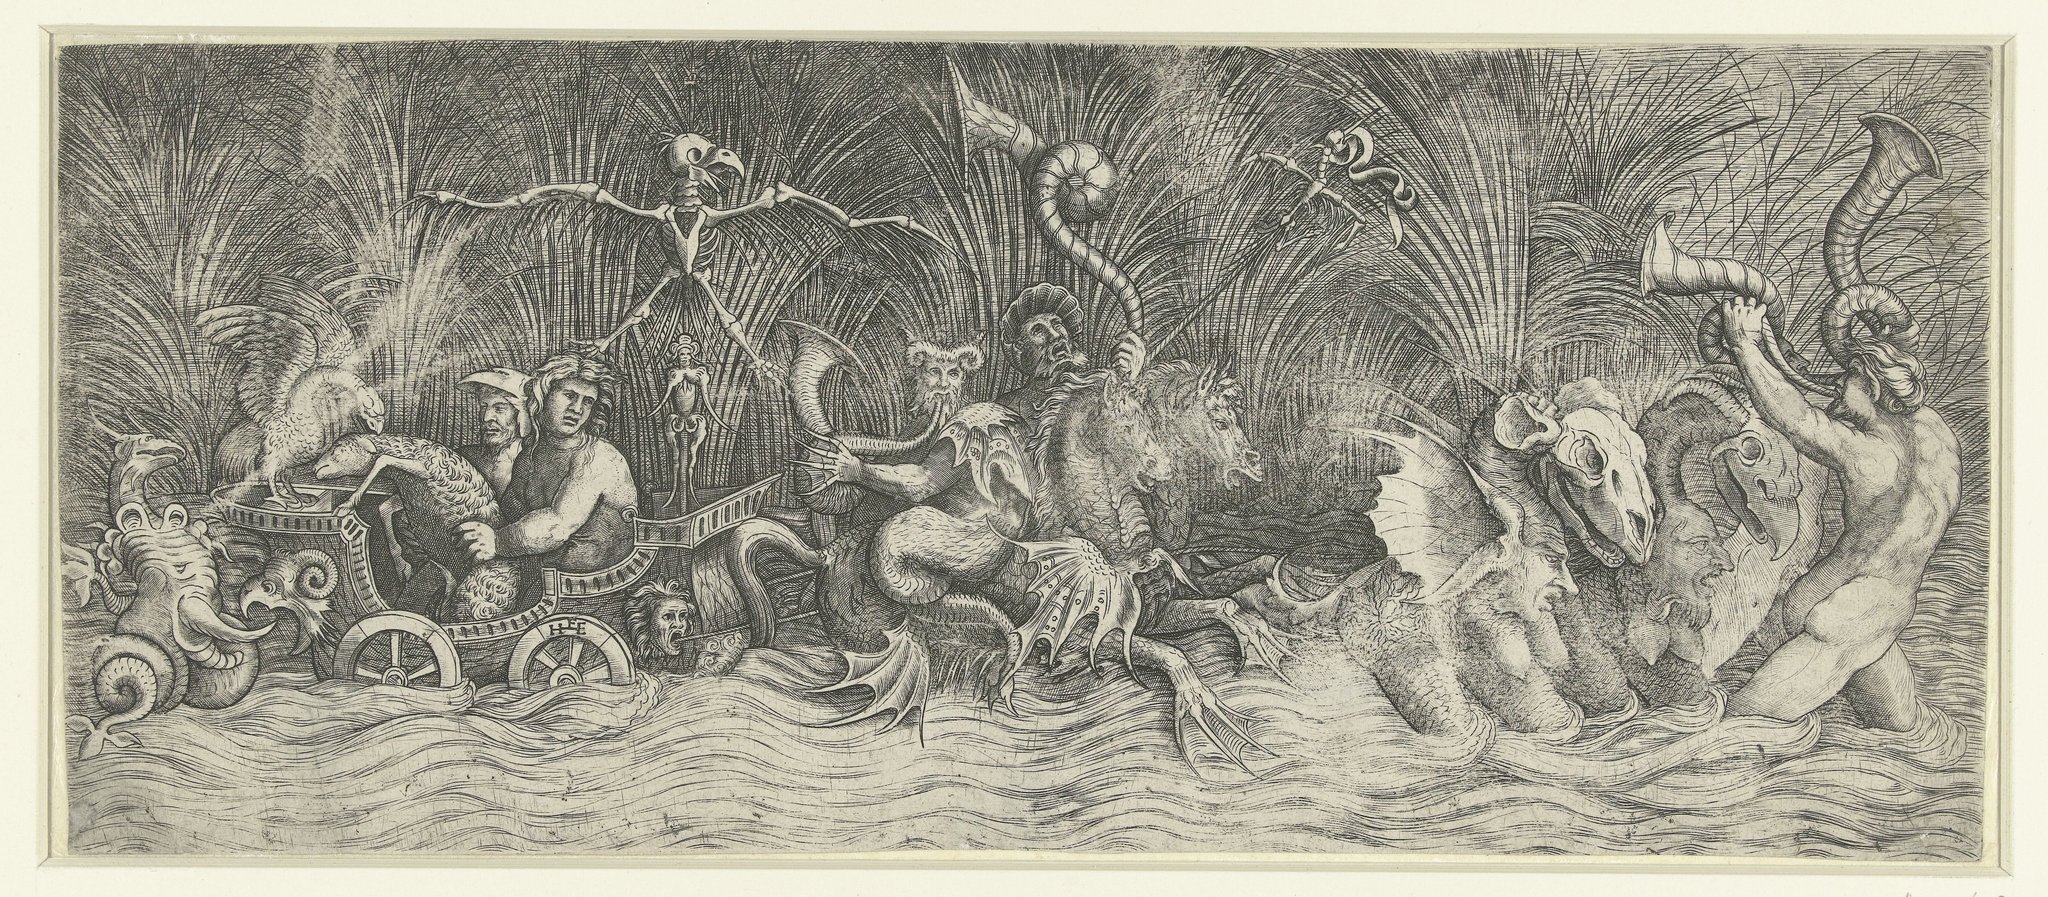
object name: print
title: Watergoden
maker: monogrammist hfe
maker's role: print maker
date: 1500-1550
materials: paper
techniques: engraving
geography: italy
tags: sea-horse, hippocamp, 'hippocampus', (horse/fish) (mythological hybrid monster), monsters of mixed human and animal shape; 'mostri' (ripa), gods of the waters: neptune and his environment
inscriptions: collector's mark: Lugt 2228